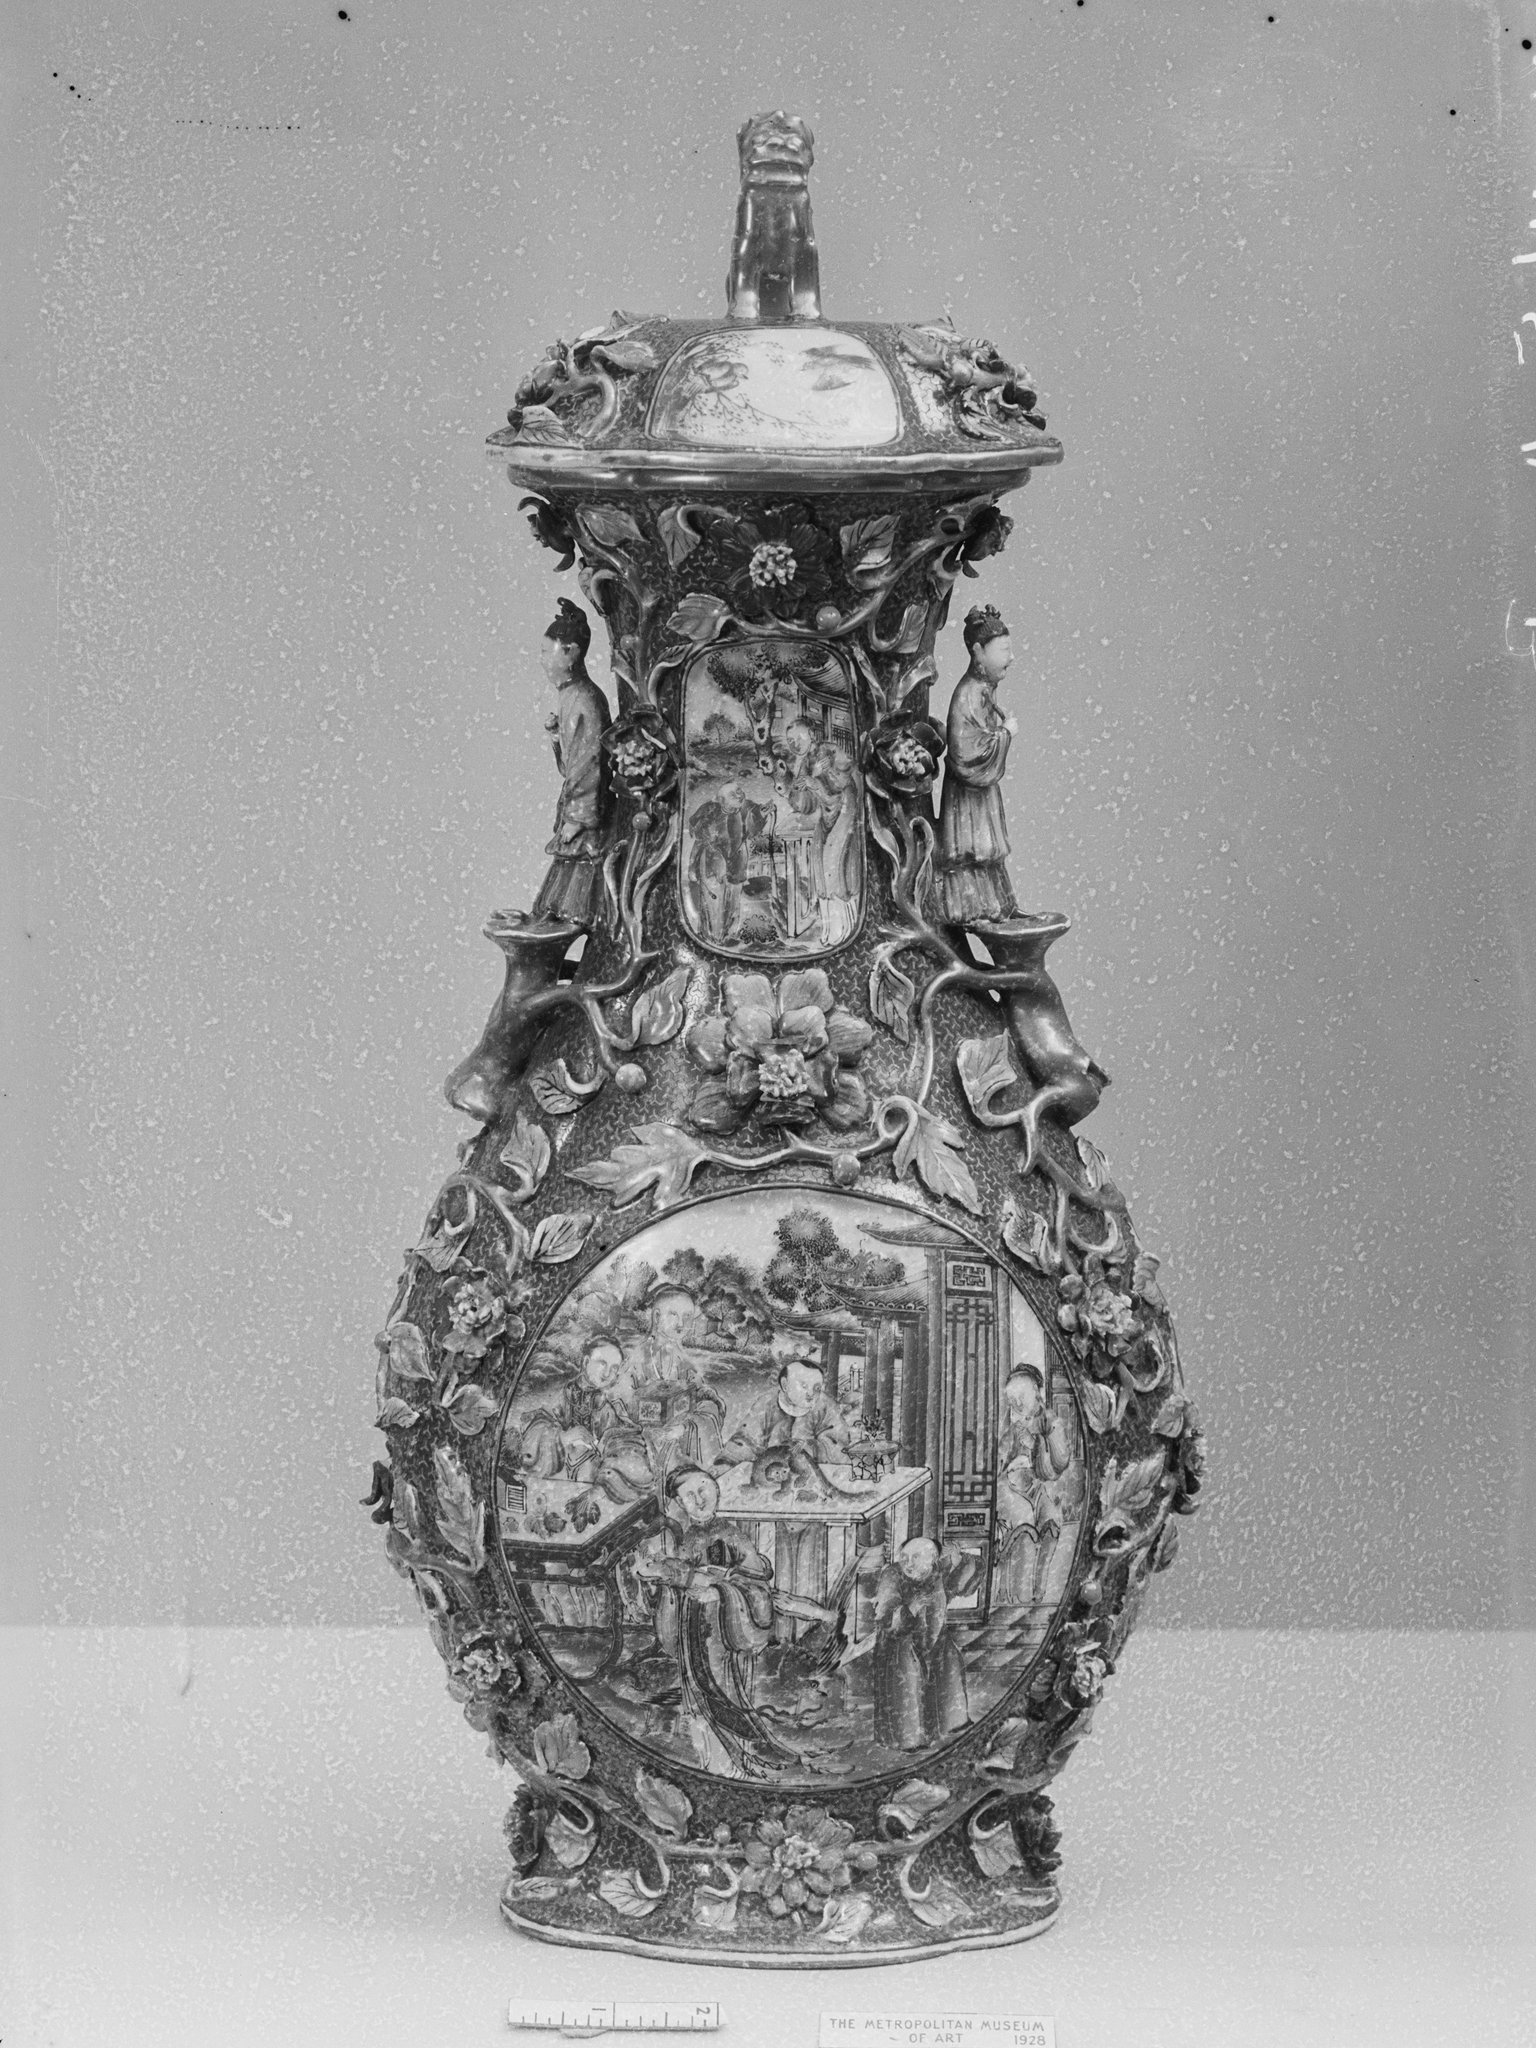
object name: covered jar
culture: chinese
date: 1767-1833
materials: enamel, porcelain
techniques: overglaze, polychrome, relief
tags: men,mythical creatures,flowers,leaves